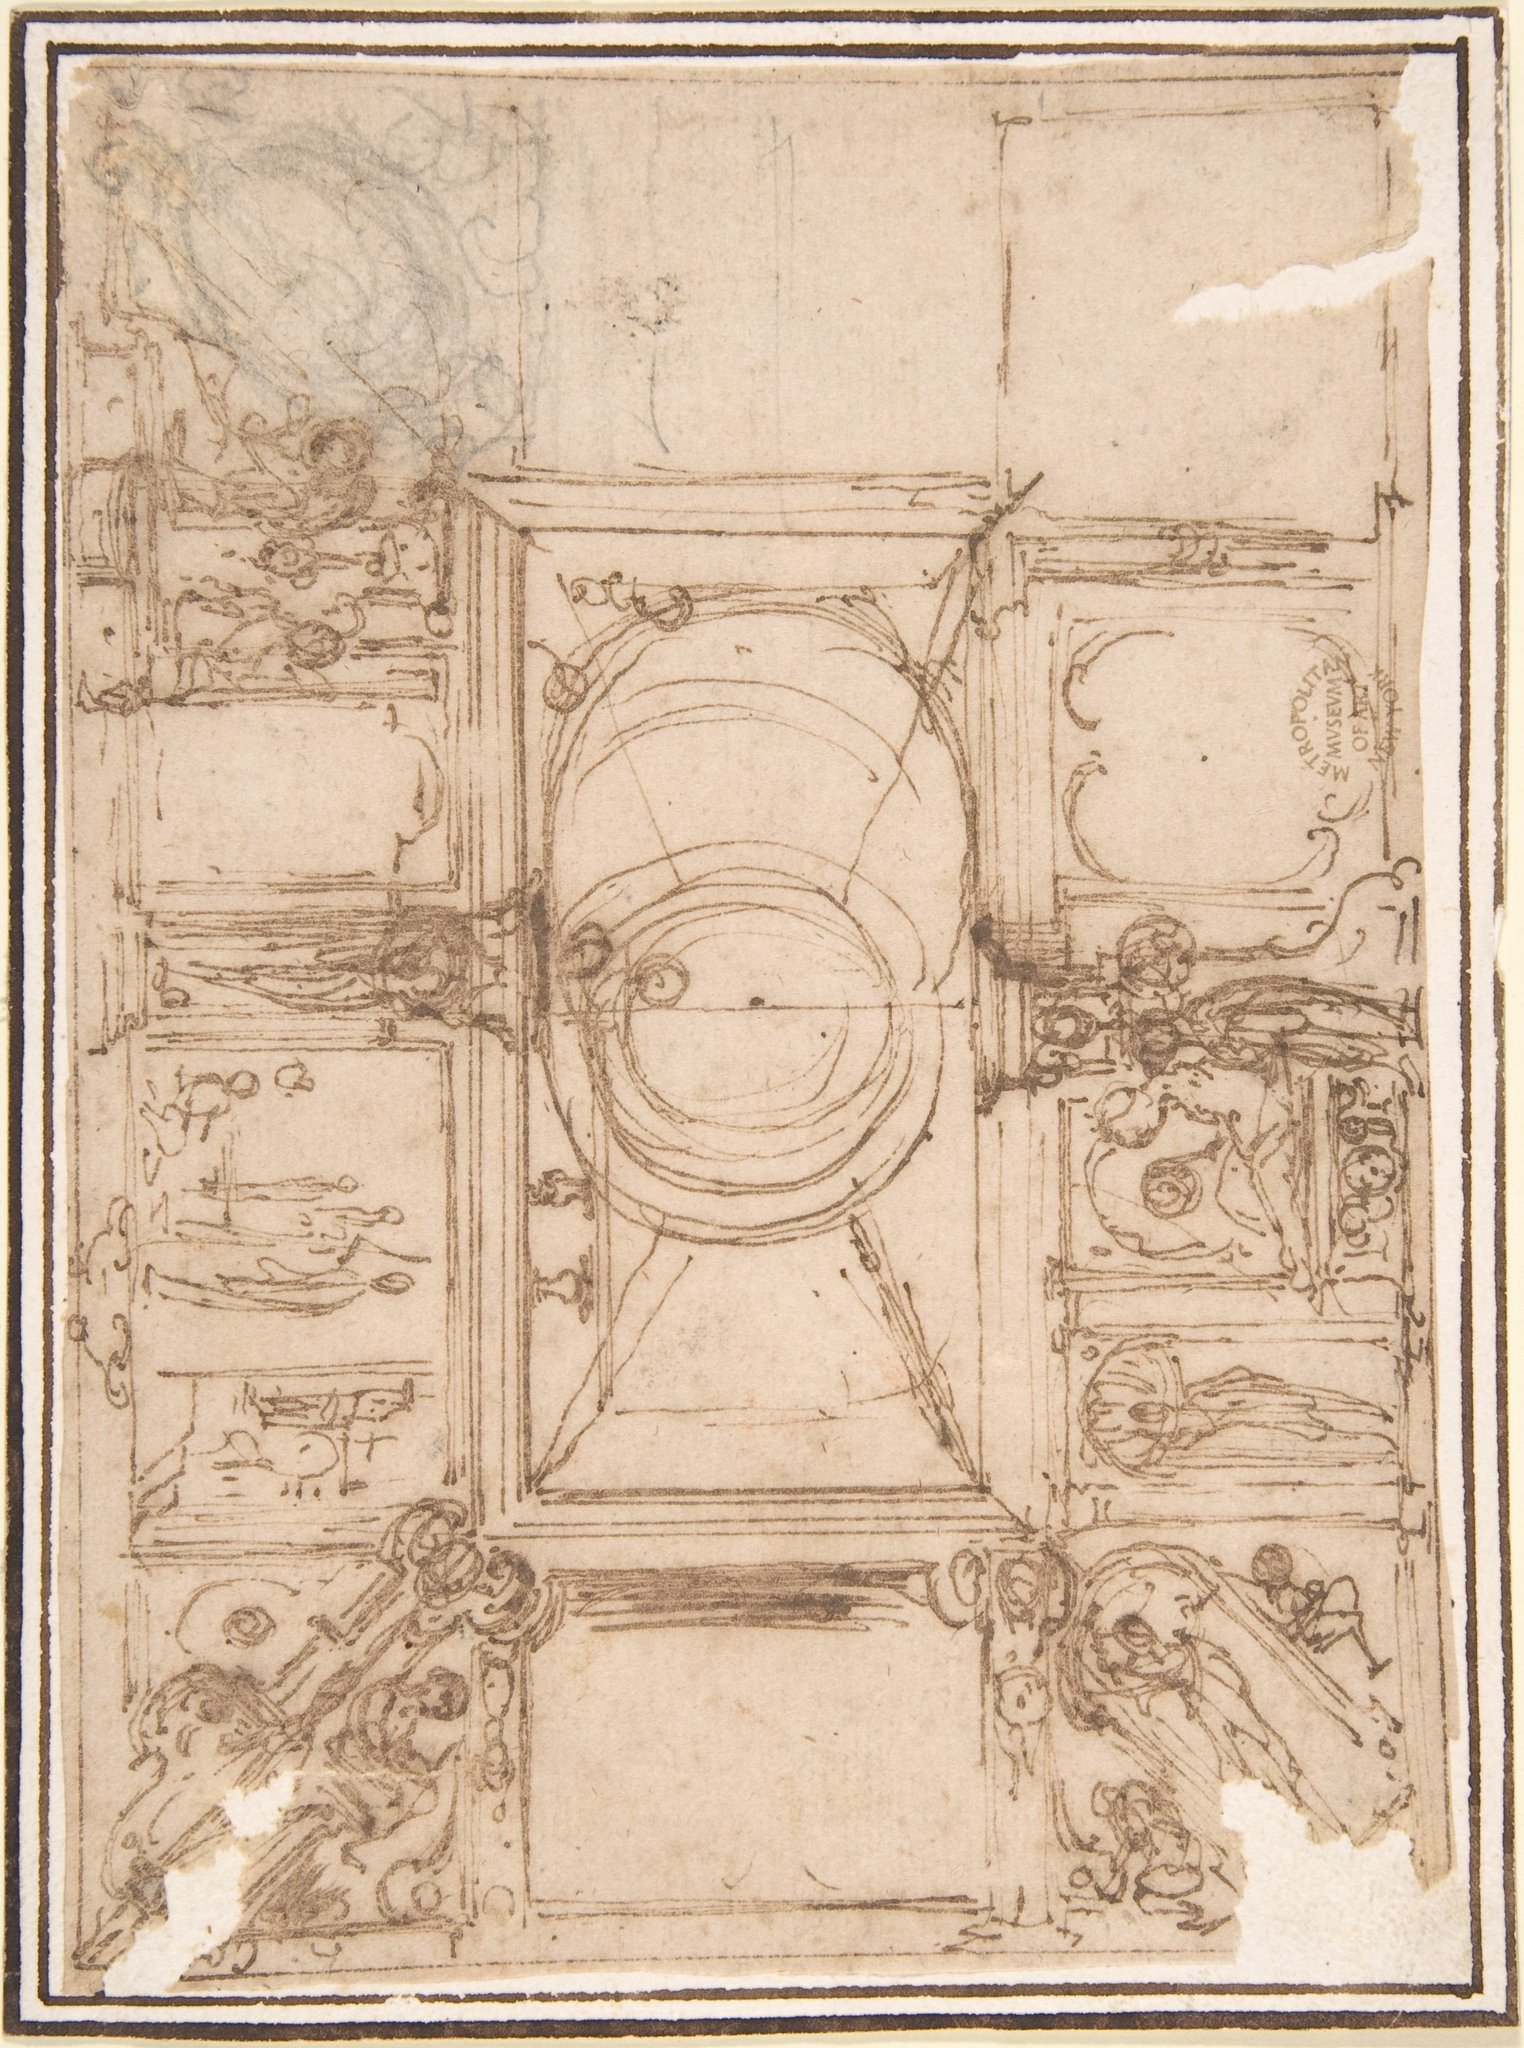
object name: drawing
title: Project for Ceiling Decoration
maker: anonymous, italian, 16th century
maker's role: artist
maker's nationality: italian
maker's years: 1550-1600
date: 1501-1600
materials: ink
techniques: pen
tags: ceilings